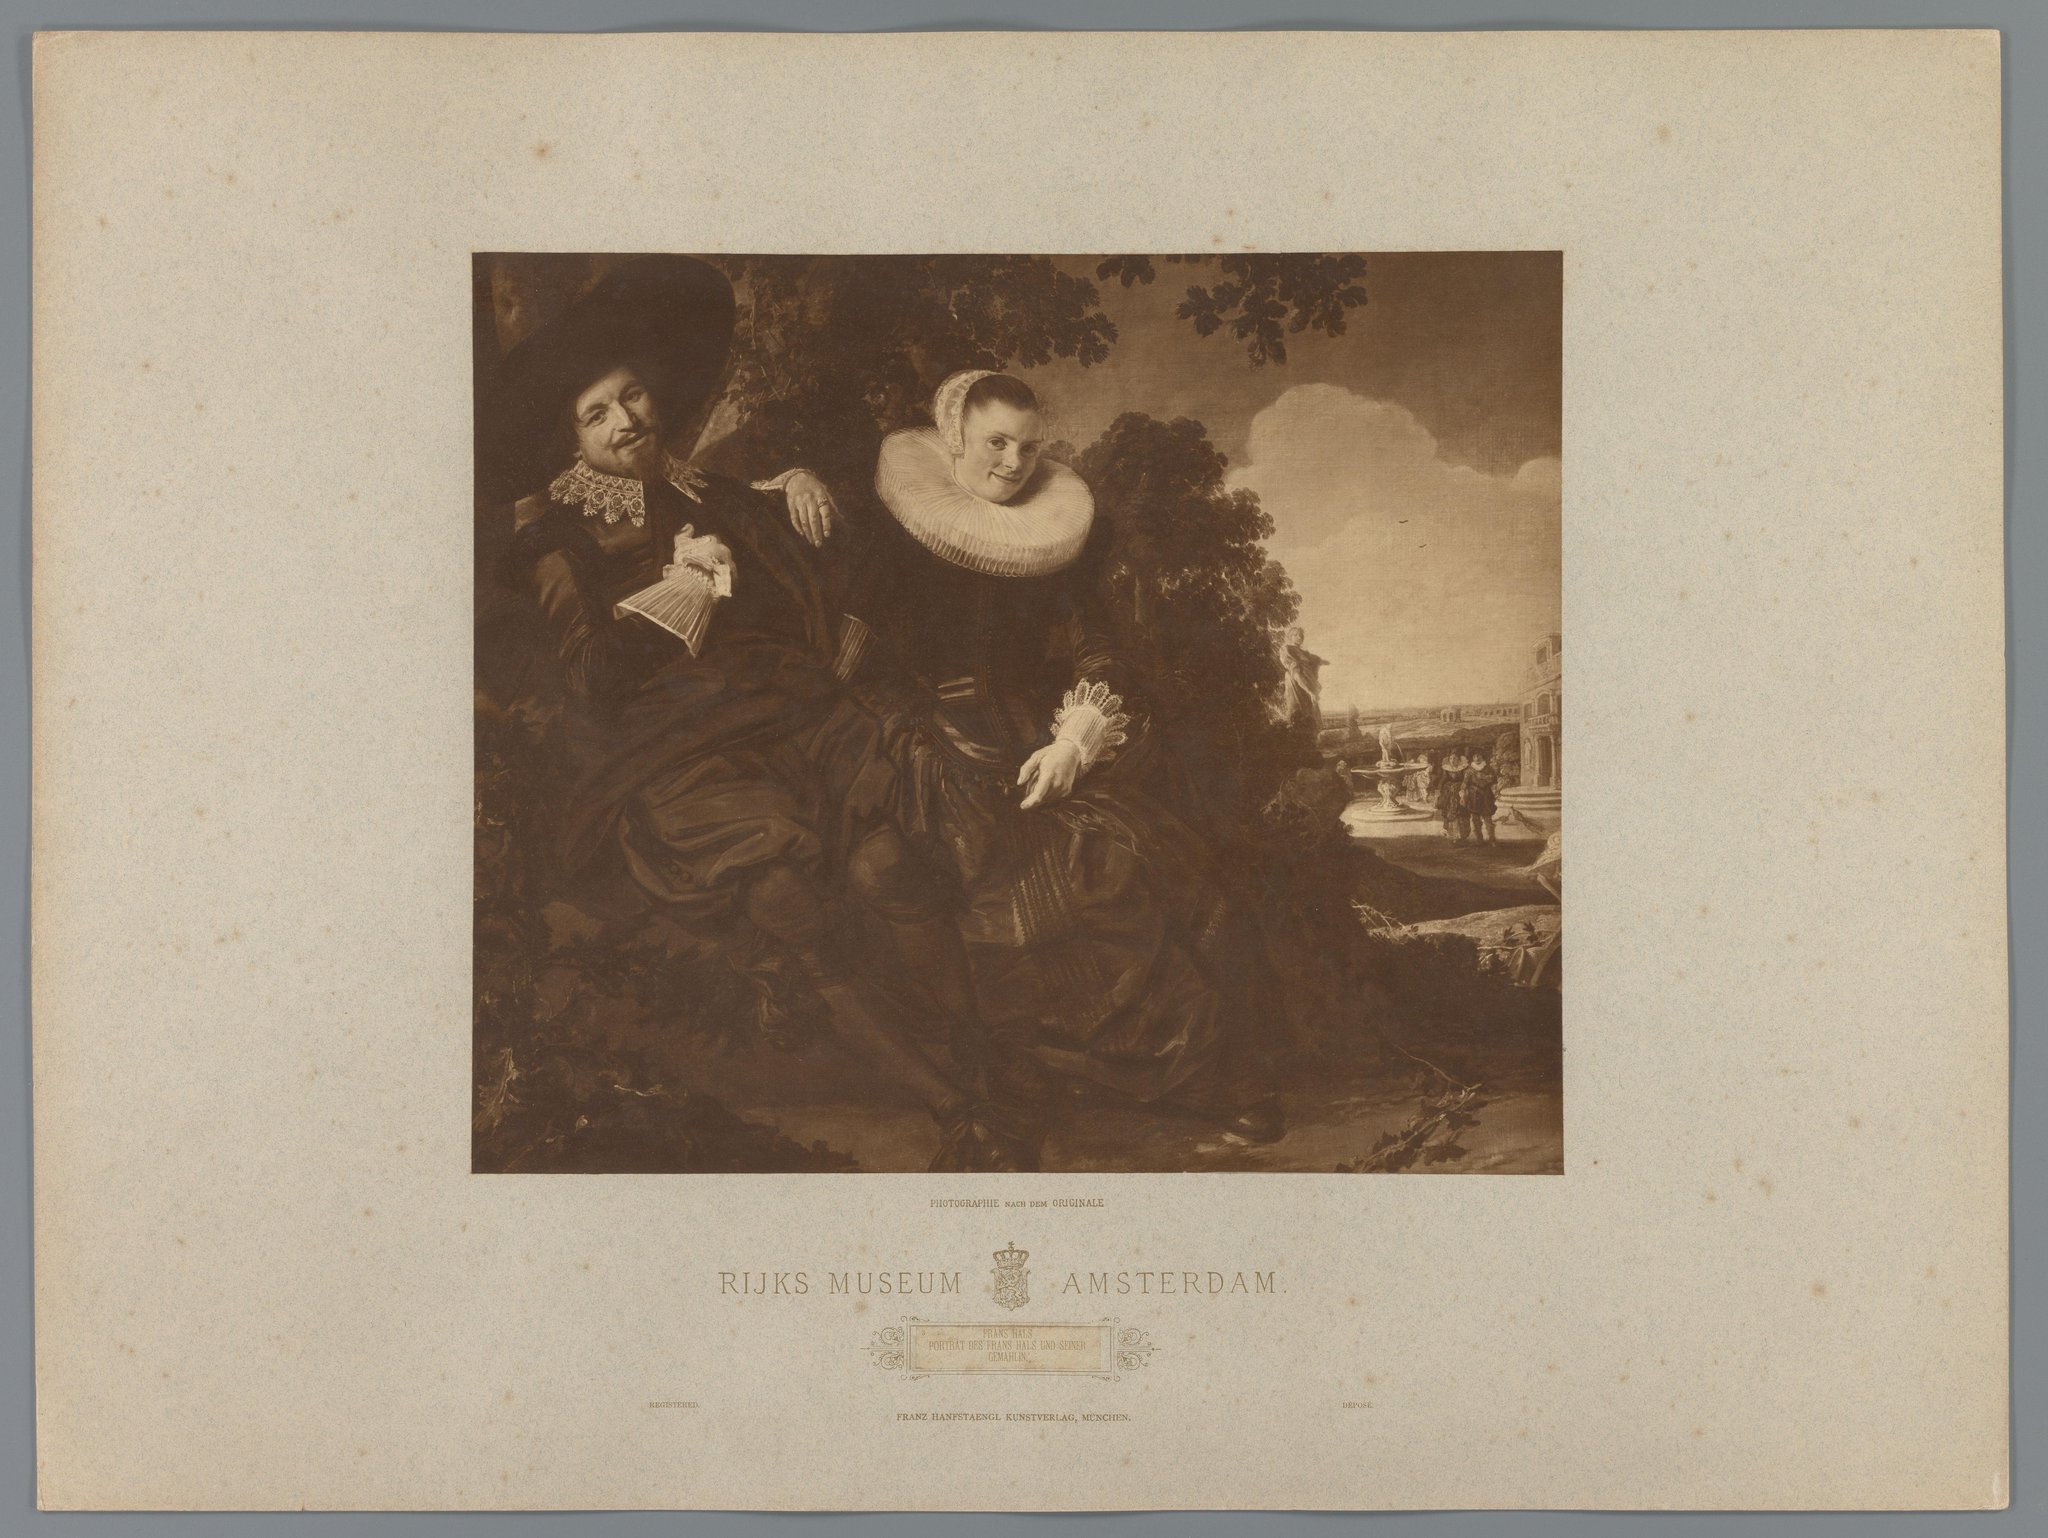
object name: photograph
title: Fotoreproductie van het schilderij Huwelijksportret van Isaac Abrahamsz Massa en Beatrix van der Laen door Frans Hals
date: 1884-1889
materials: cardboard, paper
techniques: carbon print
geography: munich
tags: garden fountain, marriage, married couple, 'matrimonium'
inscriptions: inscription: ‘Photographie nach dem Originale/ Rijks Museum Amsterdam/ Registered. Déposé.’